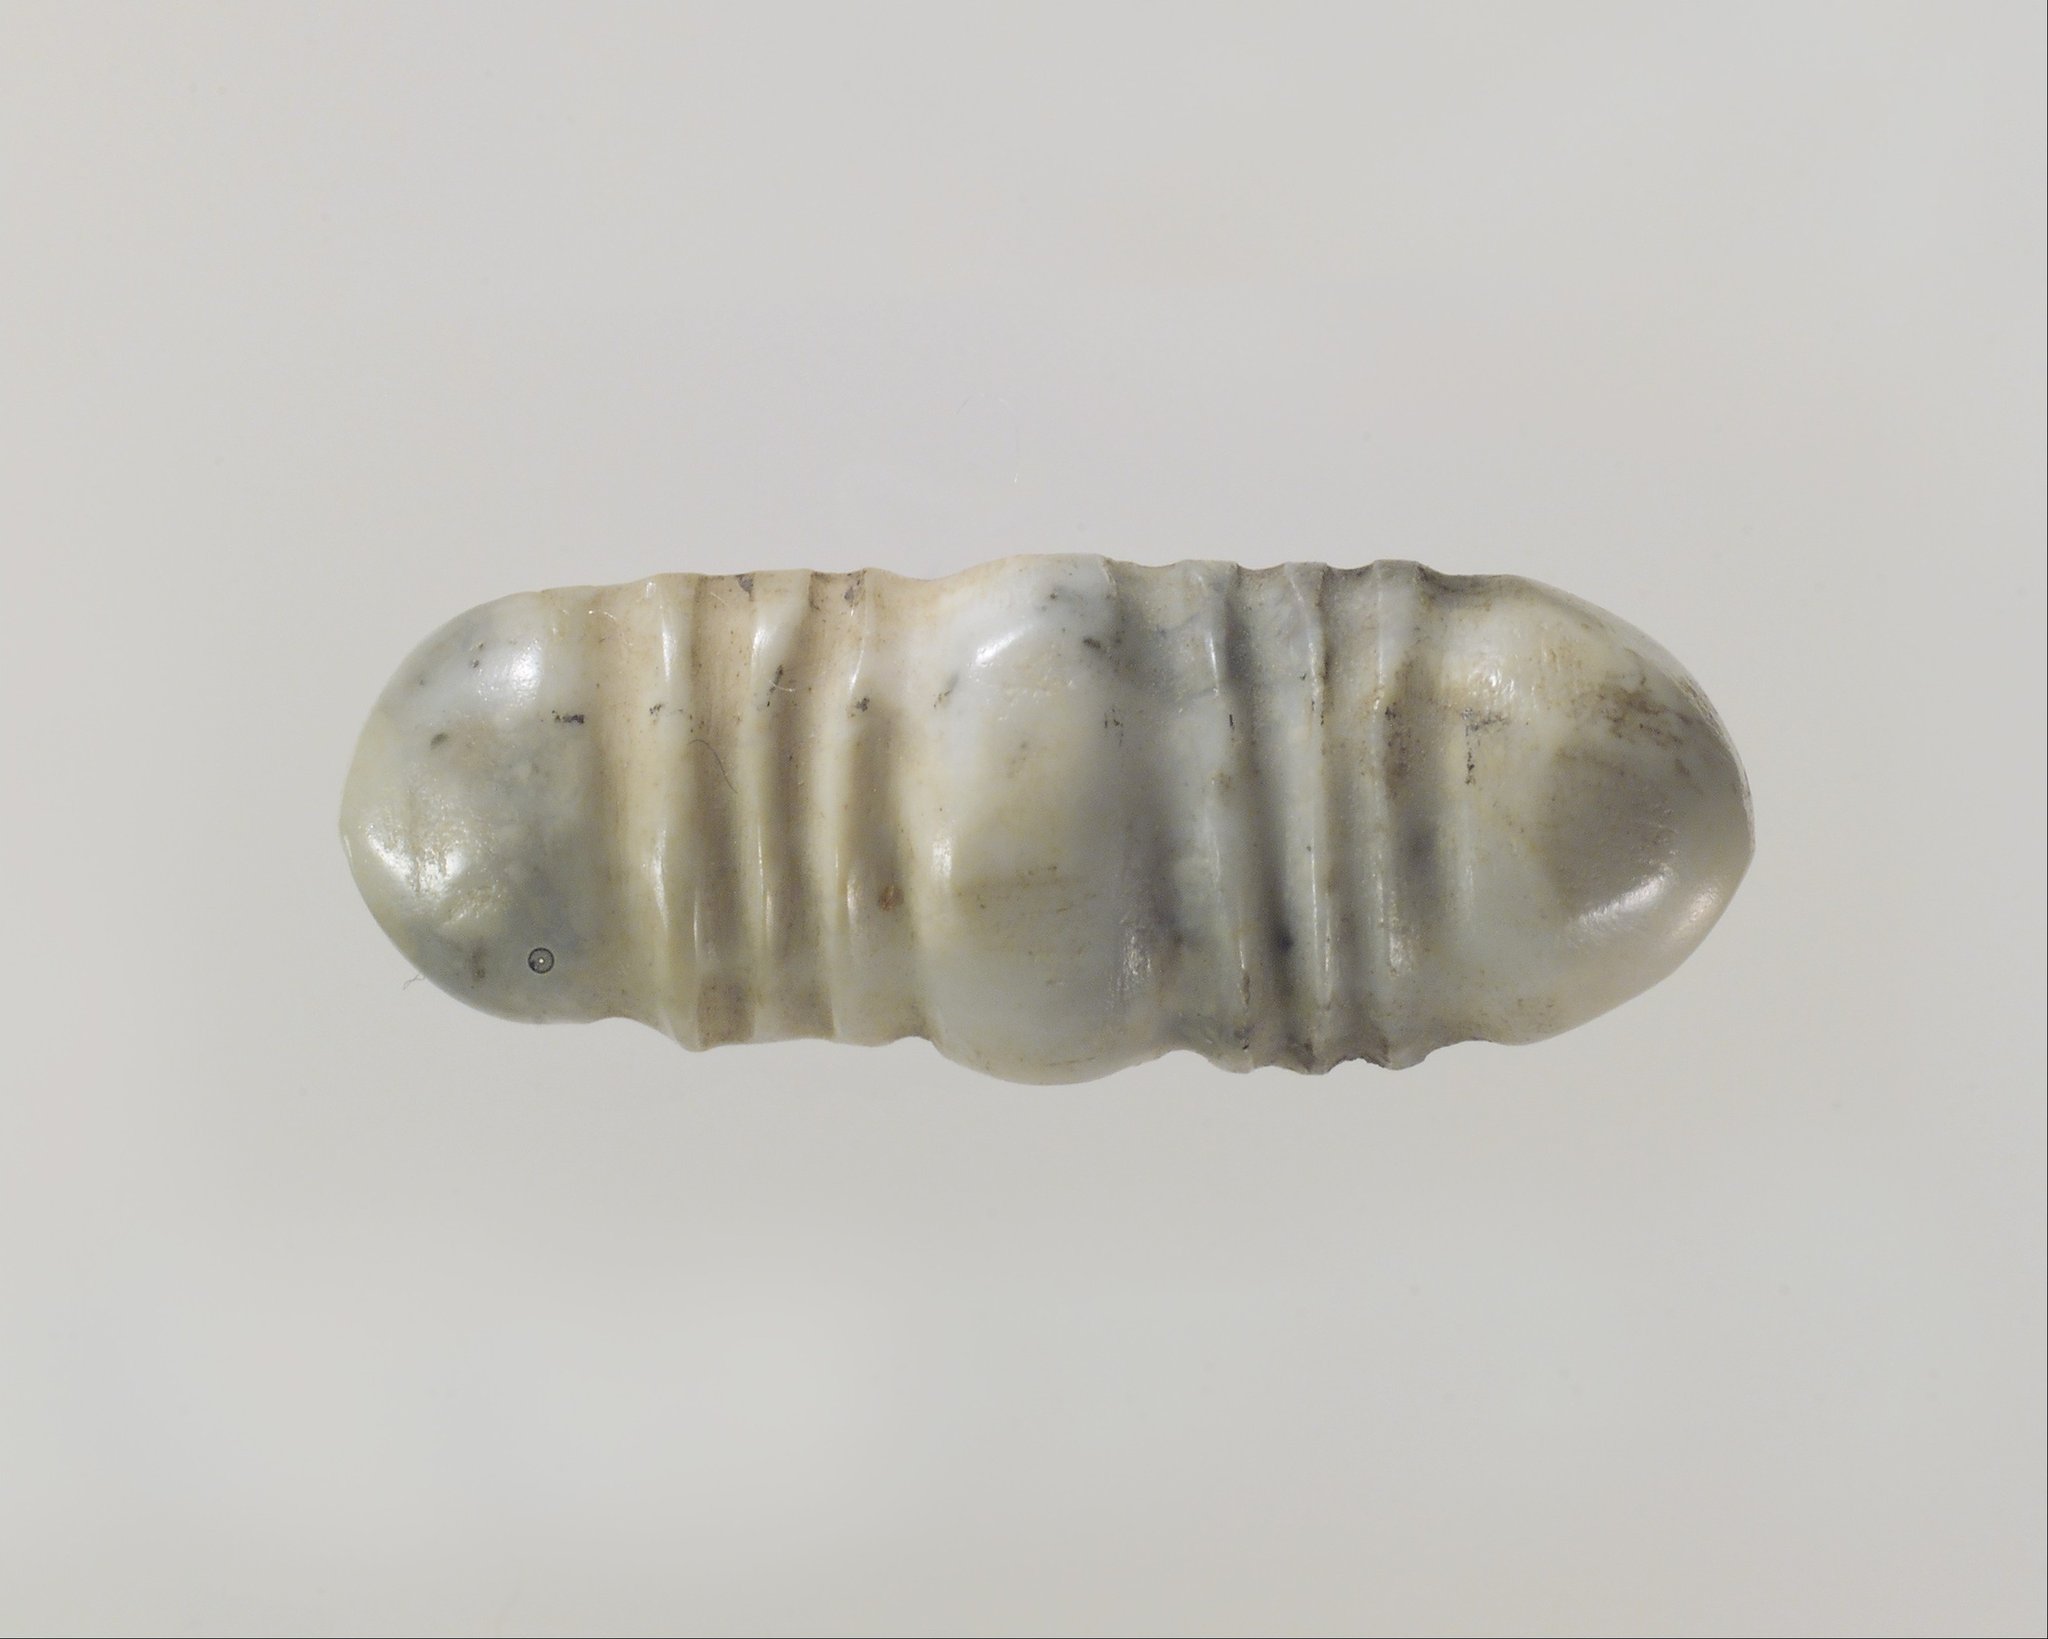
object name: ornament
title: Ornament or button for harness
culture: assyrian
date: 900-601 BCE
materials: shell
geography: mesopotamia